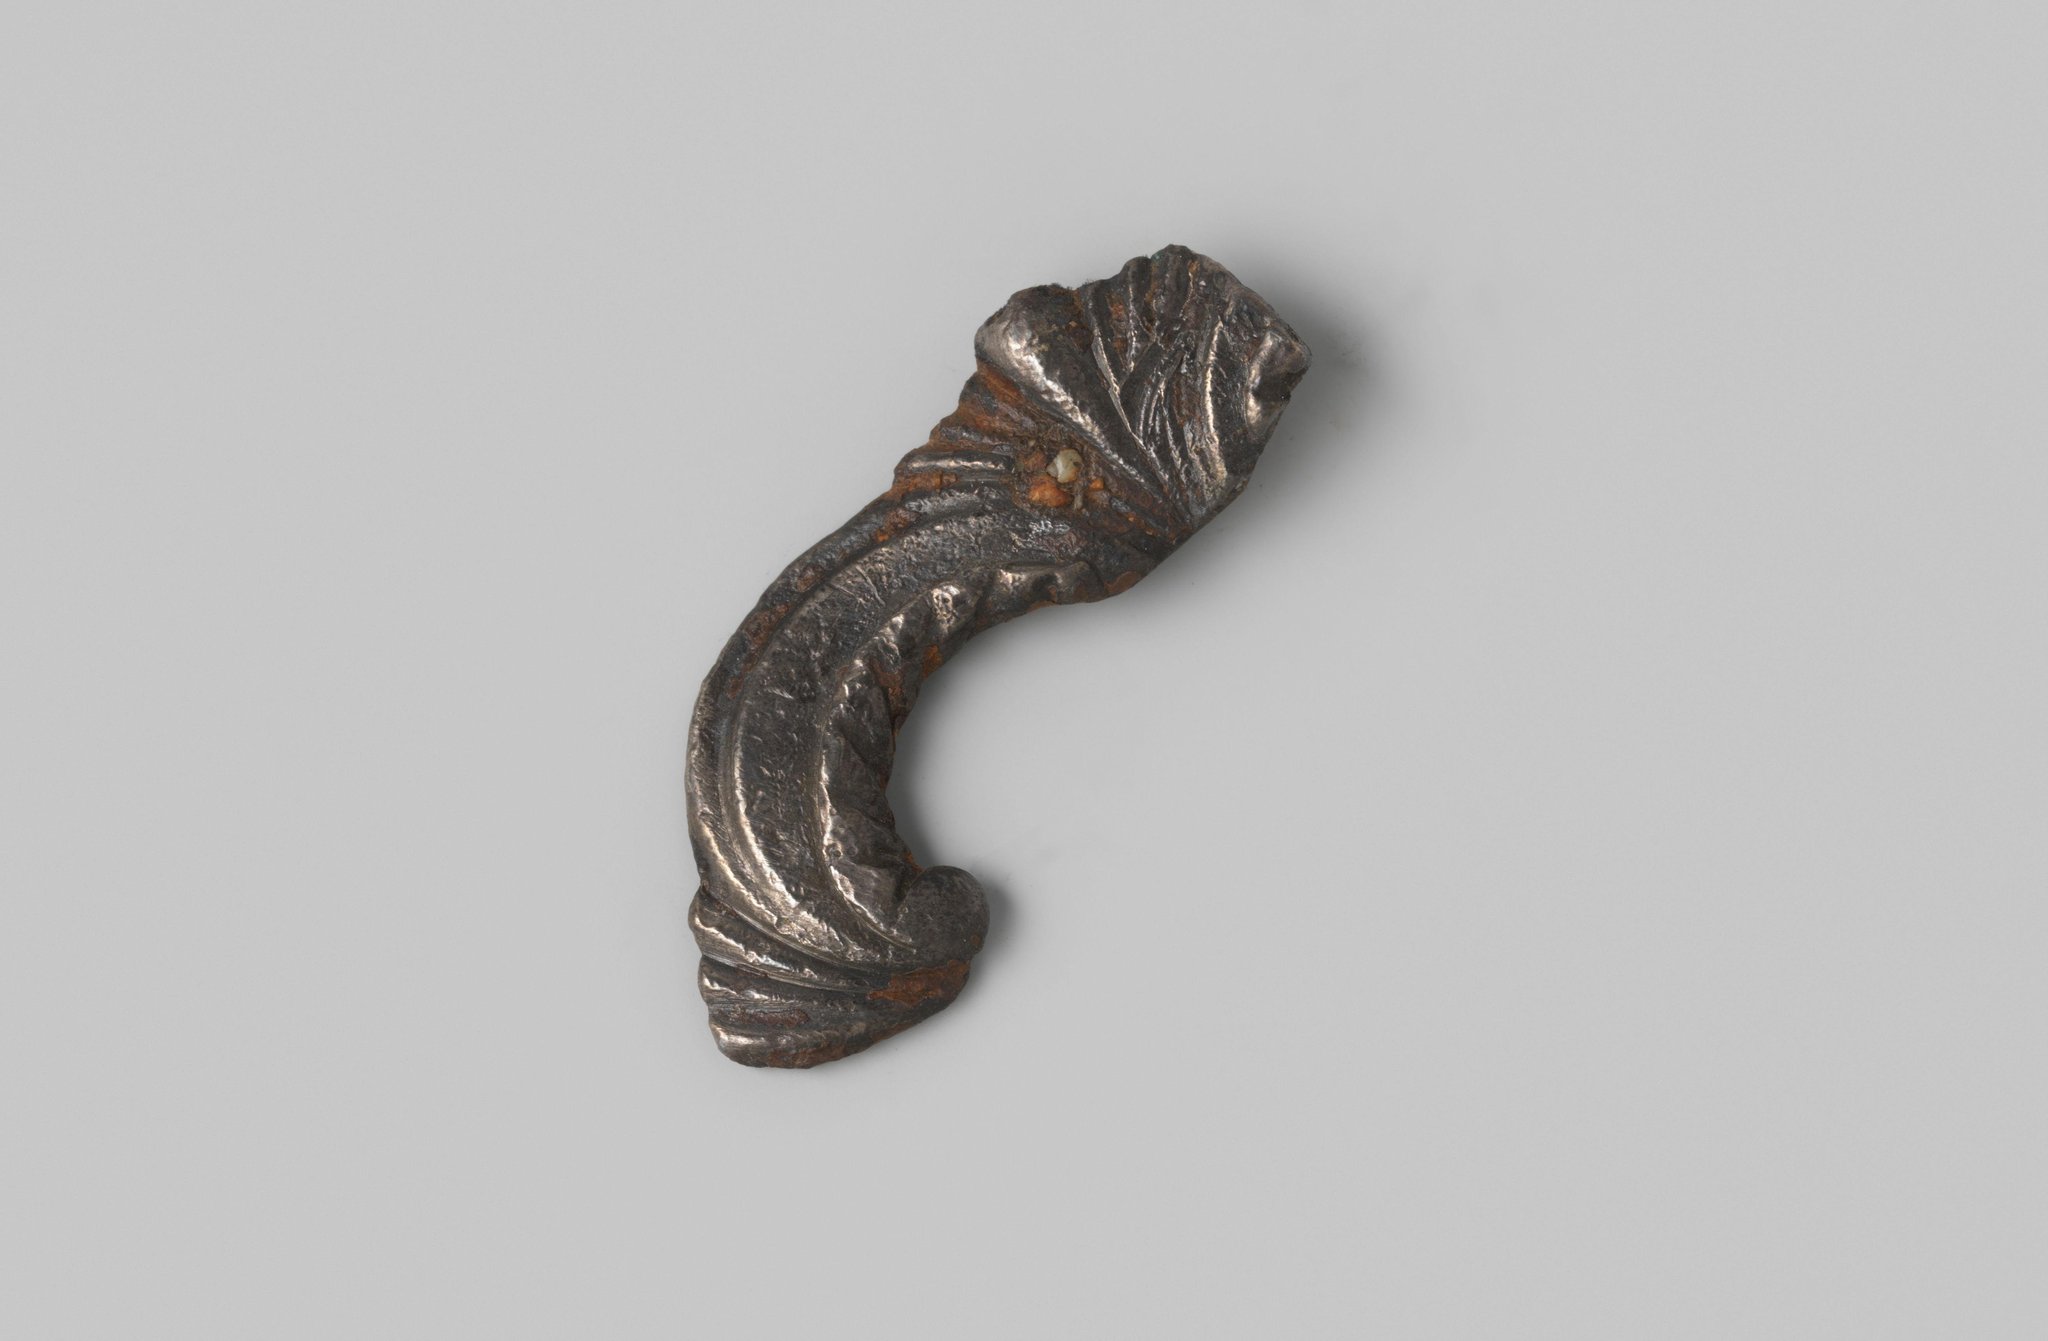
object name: buckle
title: Fragment van een gesp uit het wrak van de Oost-Indiëvaarder Hollandia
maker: Anonymous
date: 1700-1743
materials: silver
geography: netherlands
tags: verenigde oostindische compagnie, hollandia (schip), annet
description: Buckle, not identifiable; fragm of ring with spindle eye, curving outline, scrolling decoration of shell motif.